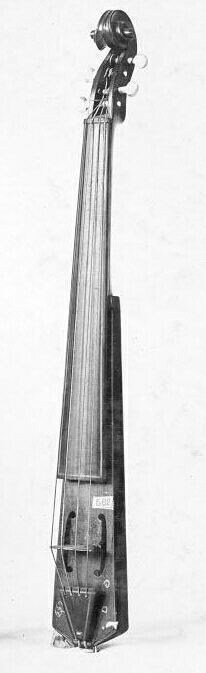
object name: pochette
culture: french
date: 1701-1800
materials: ivory, wood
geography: france